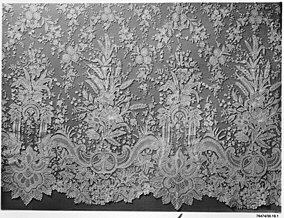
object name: flounce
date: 1801-1900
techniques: lace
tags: flowers,plants